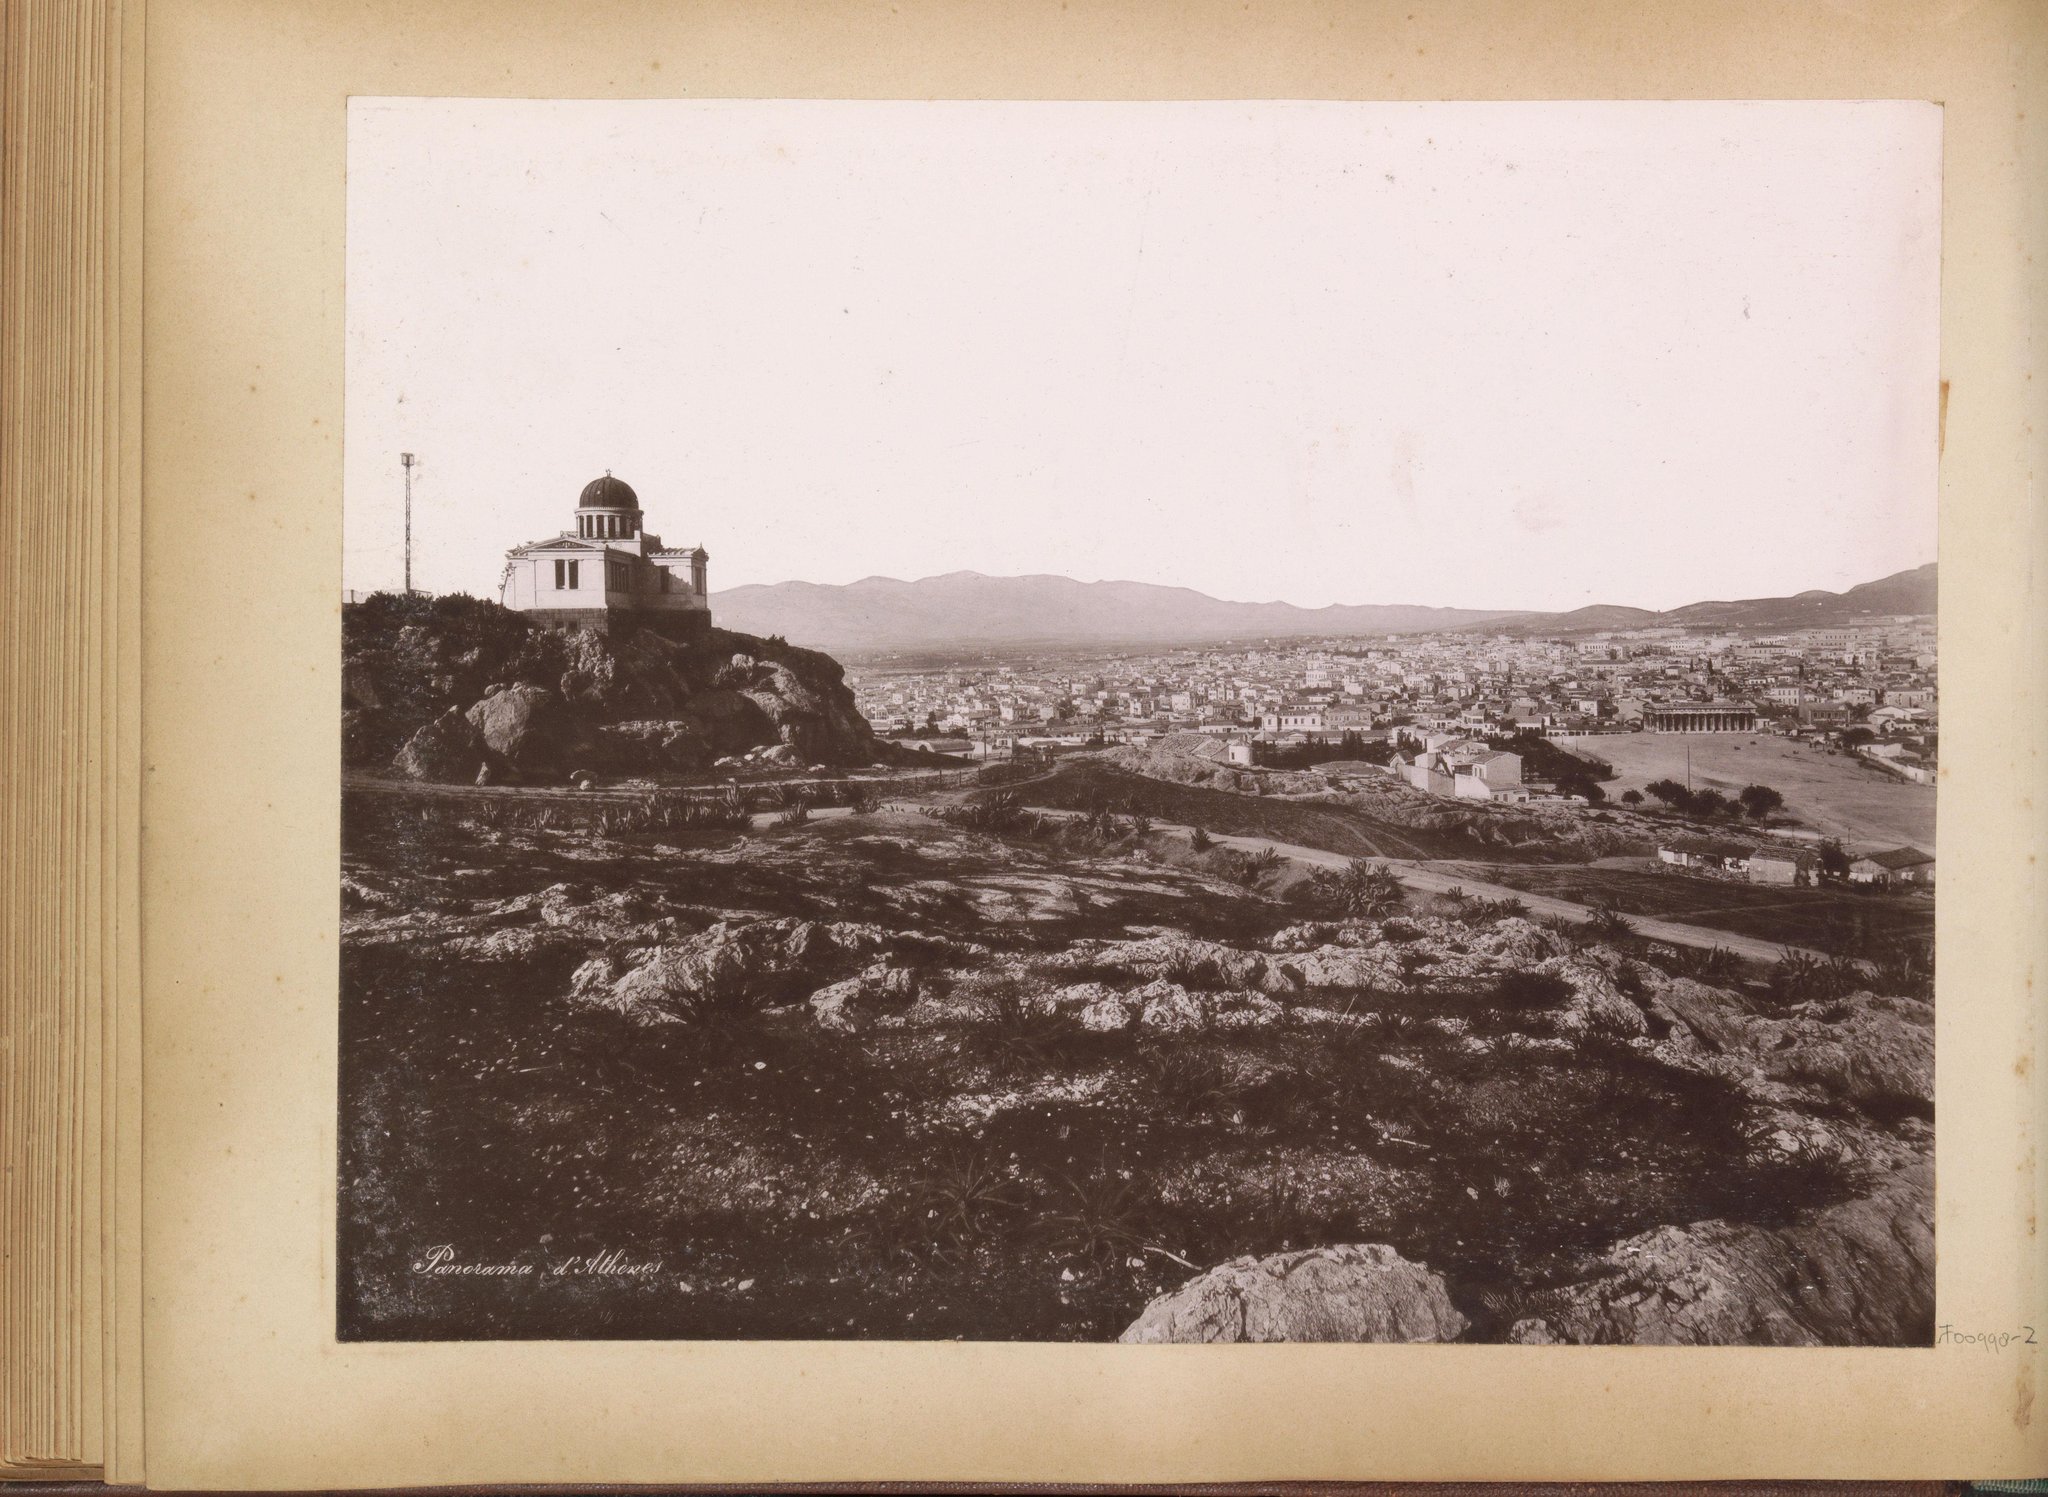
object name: photograph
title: Panorama d'Athènes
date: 1880-1890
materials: paper, photographic support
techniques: photograph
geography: athens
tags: prospect of city, town panorama, silhouette of city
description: Linkerdeel van een panorama van Athene bestaande uit twee foto's. Onderdeel van Reisalbum met foto's van bezienswaardigheden in Frankrijk, Griekenland en Turkije.